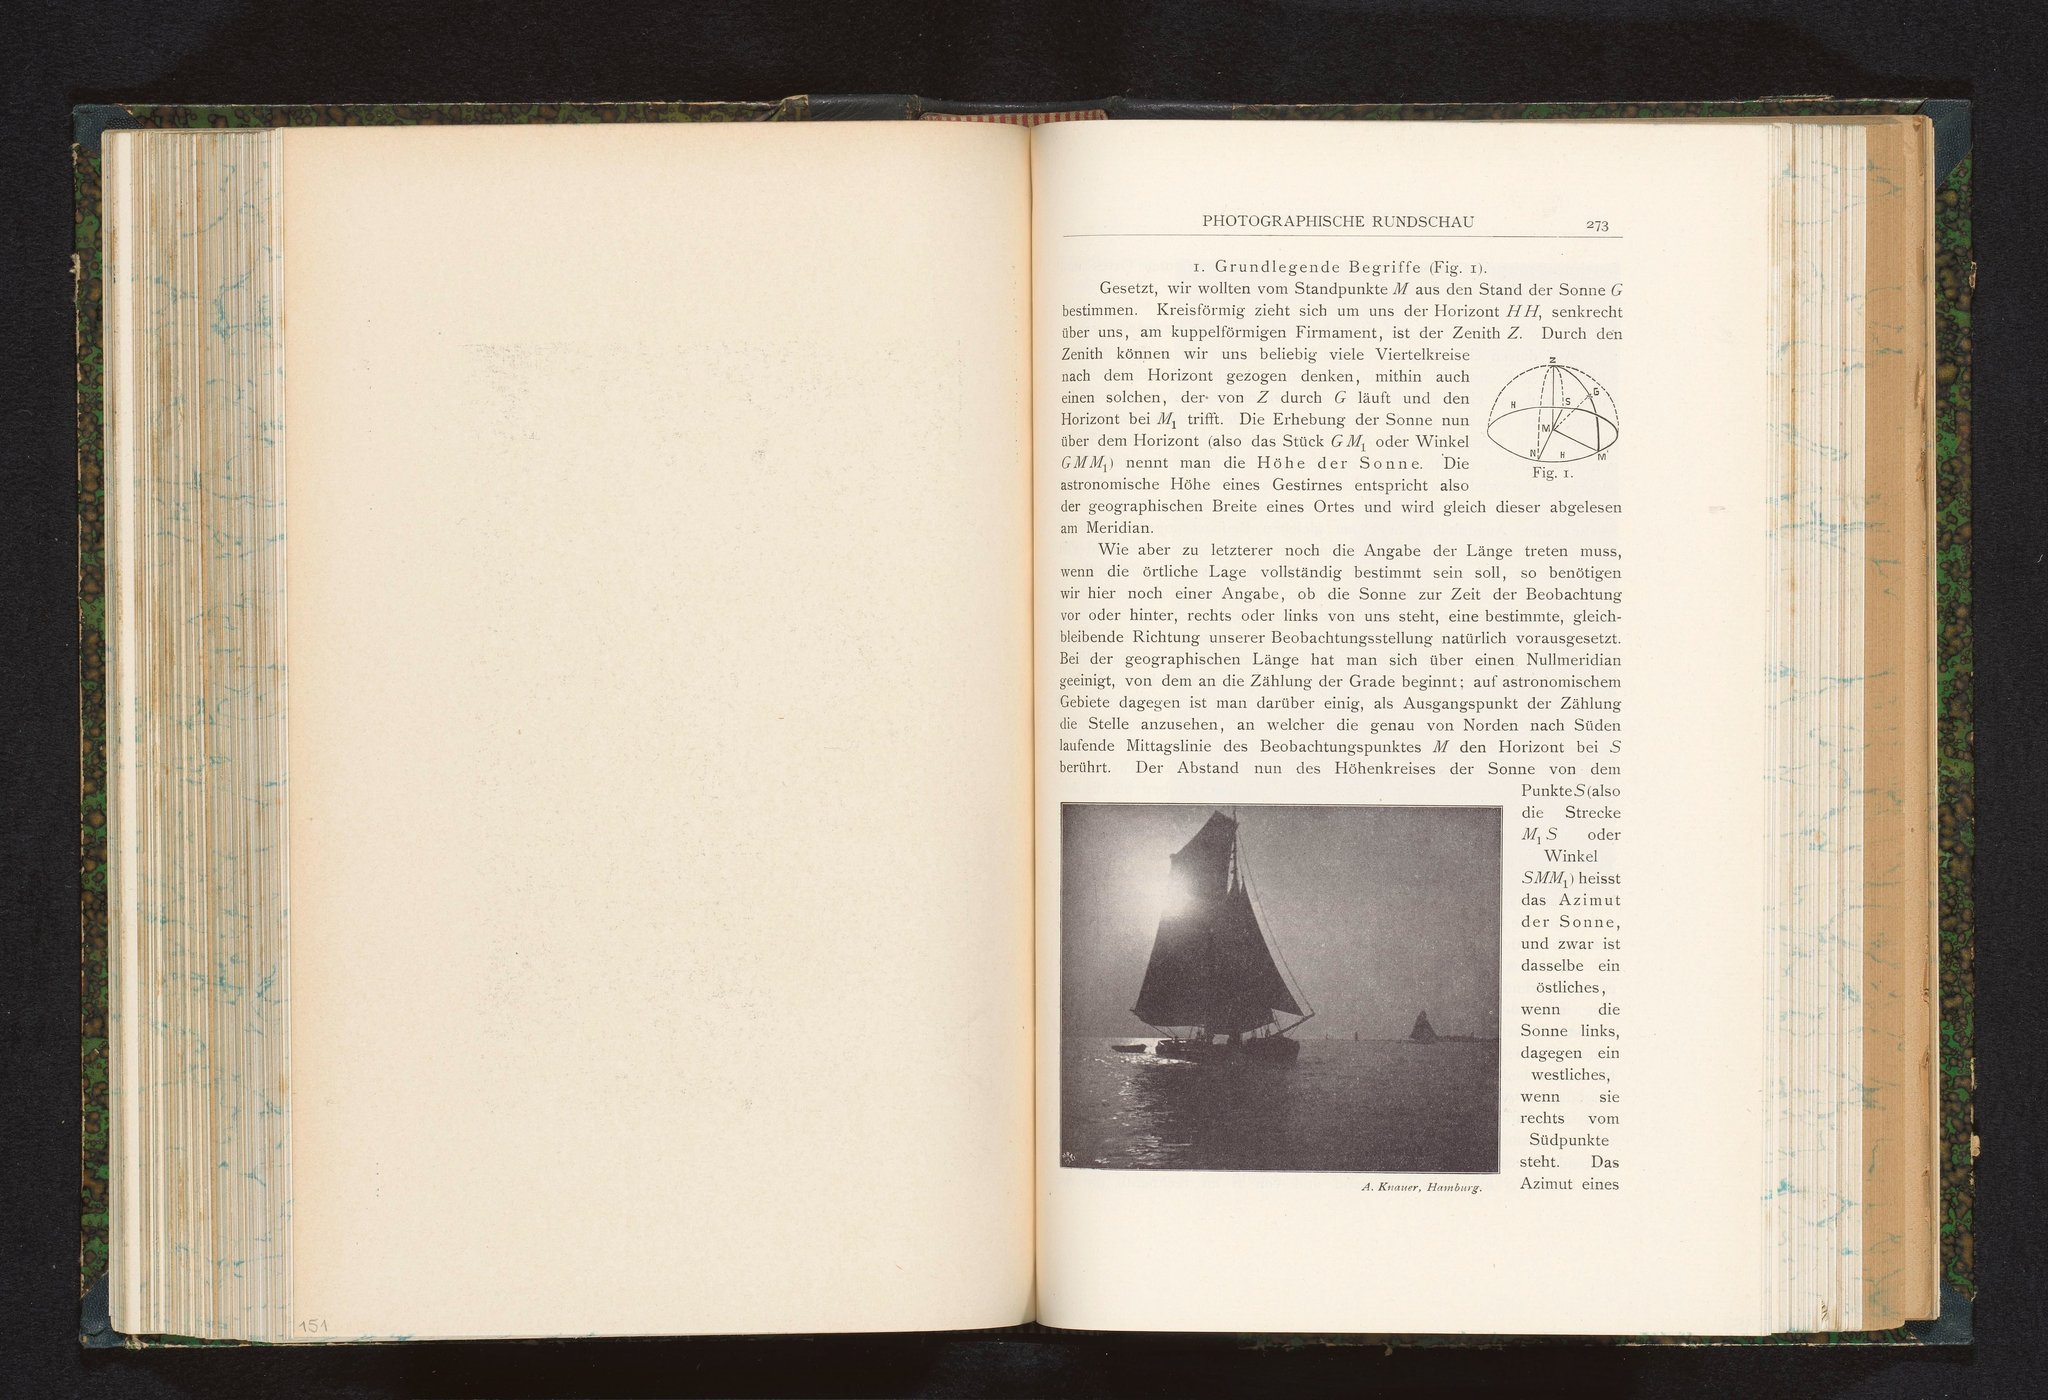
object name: photomechanical print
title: Zeilschip op het water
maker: a. knauer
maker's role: fotograaf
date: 1894-1899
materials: paper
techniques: autotype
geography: berlin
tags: sailing-ship, sailing-boat, sea (seascape)